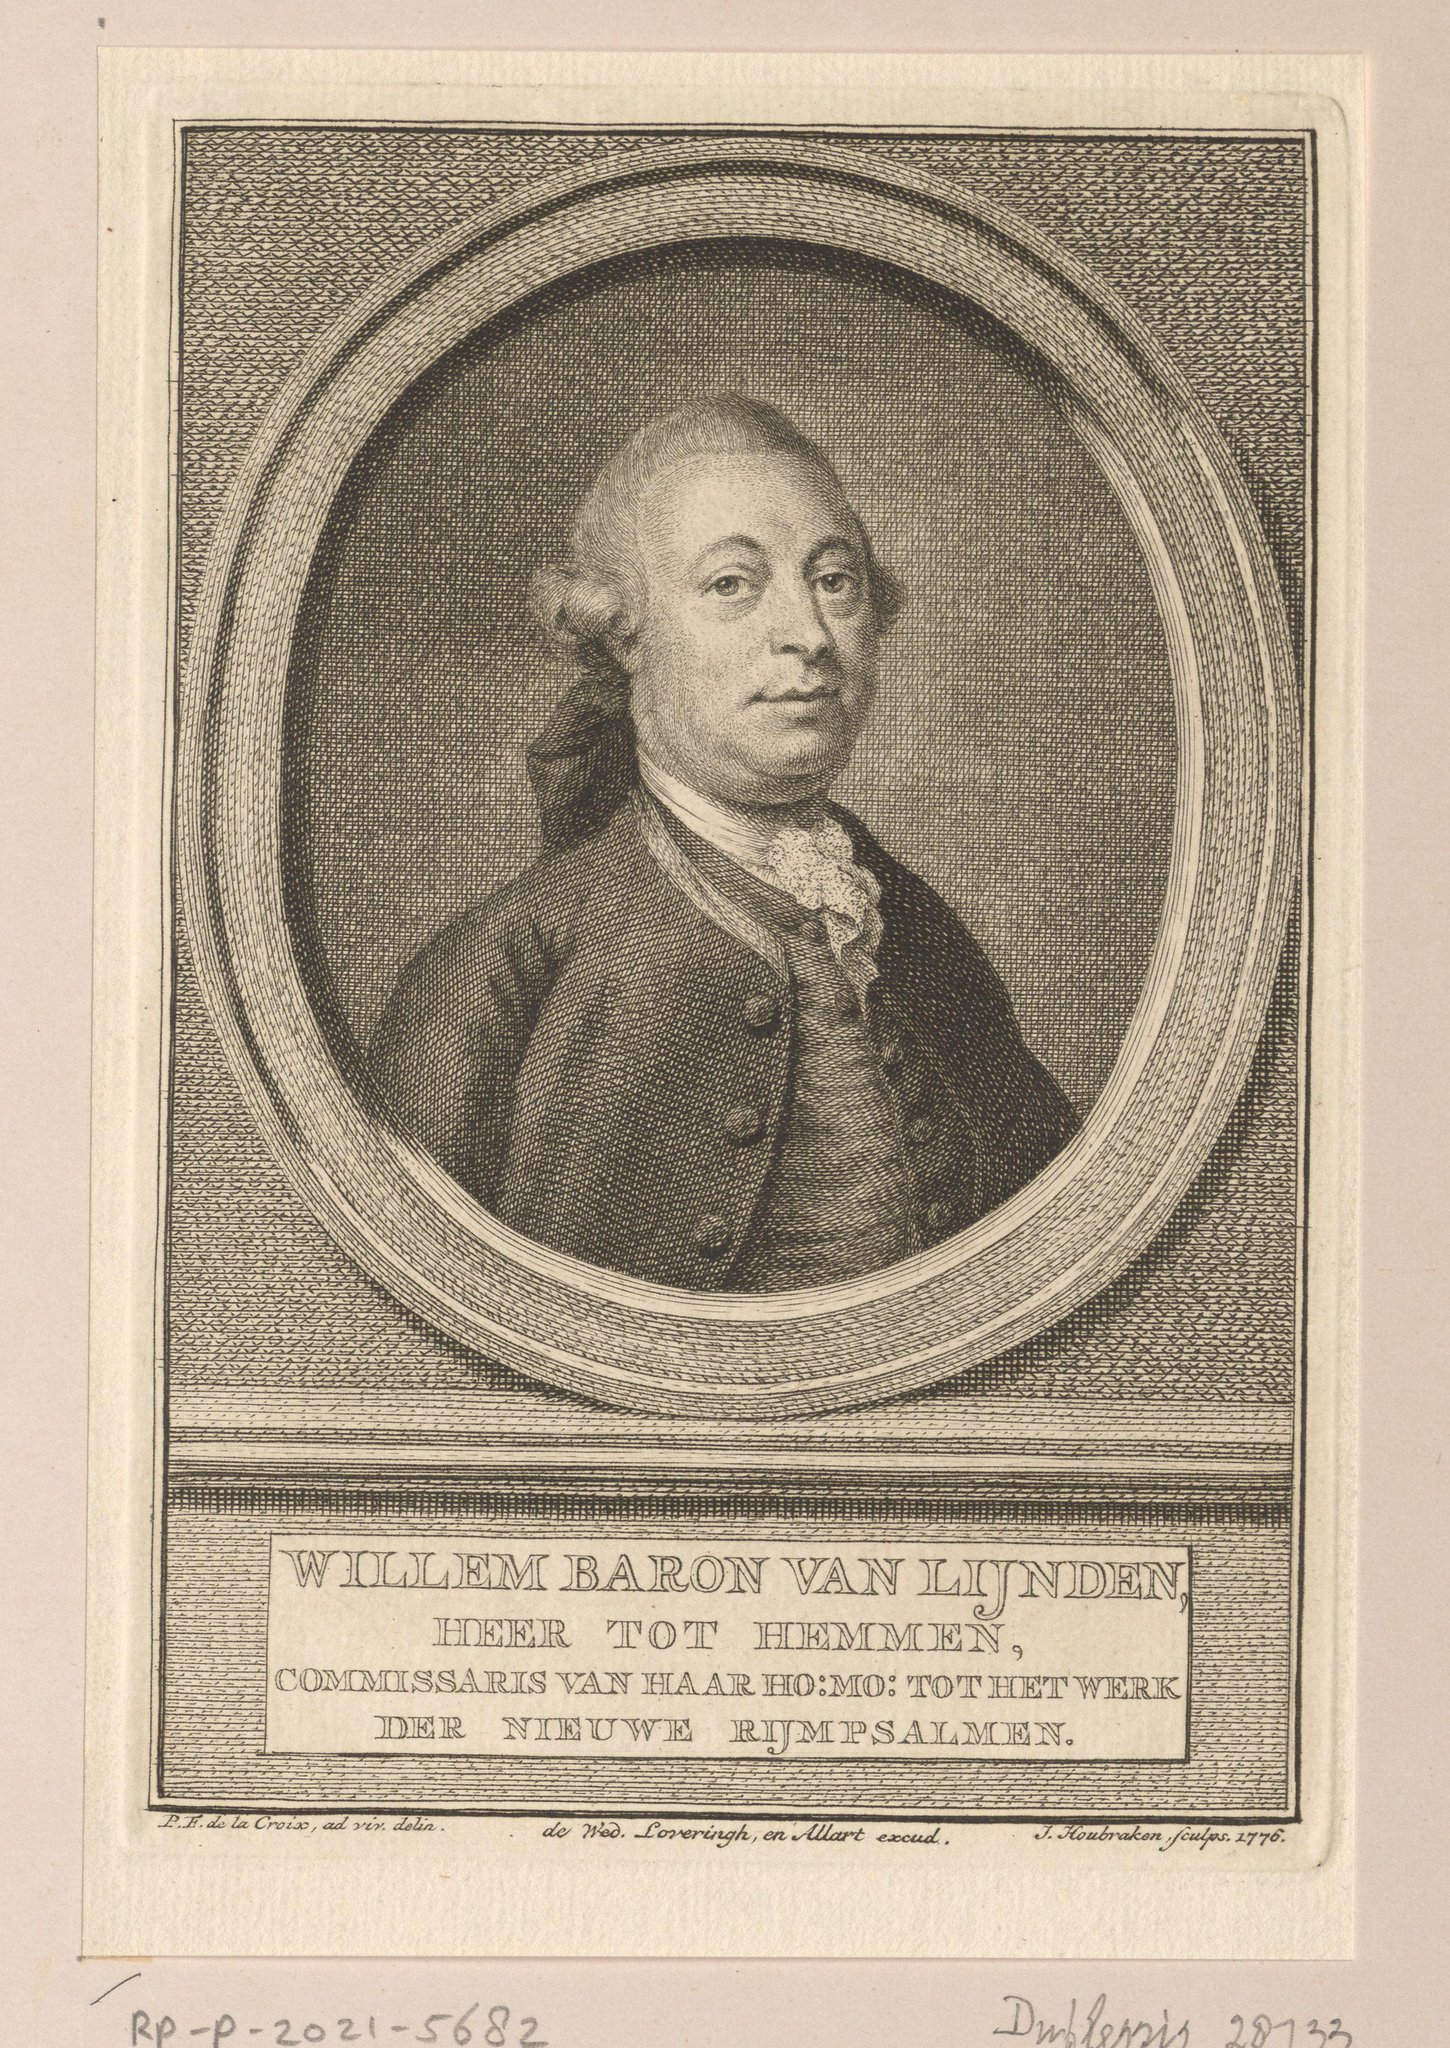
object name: book illustration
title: Portret van Willem Frans Godard van Lynden tot Hemmen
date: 1776-1777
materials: paper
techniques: engraving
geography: amsterdam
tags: utrecht, ornament ~ medallion, historical persons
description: Prent waarschijnlijk uit: Iperen, Josua van. Kerkelyke historie van het psalm-gesang der Christenen (...). Amsterdam: weduwe Loveringh en Johannes Allart, 1777, dl. 1.